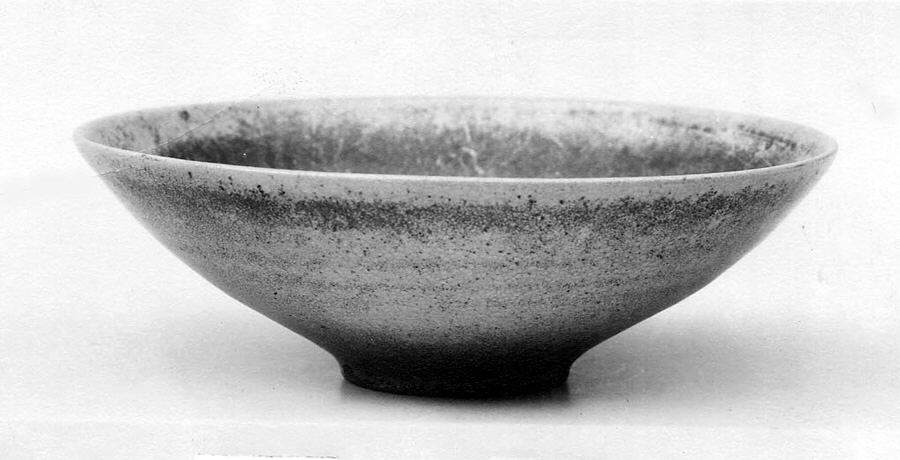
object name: teabowl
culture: japanese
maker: ninsei ii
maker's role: artist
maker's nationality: japanese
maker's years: 1658-1868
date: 1650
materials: clay, glaze